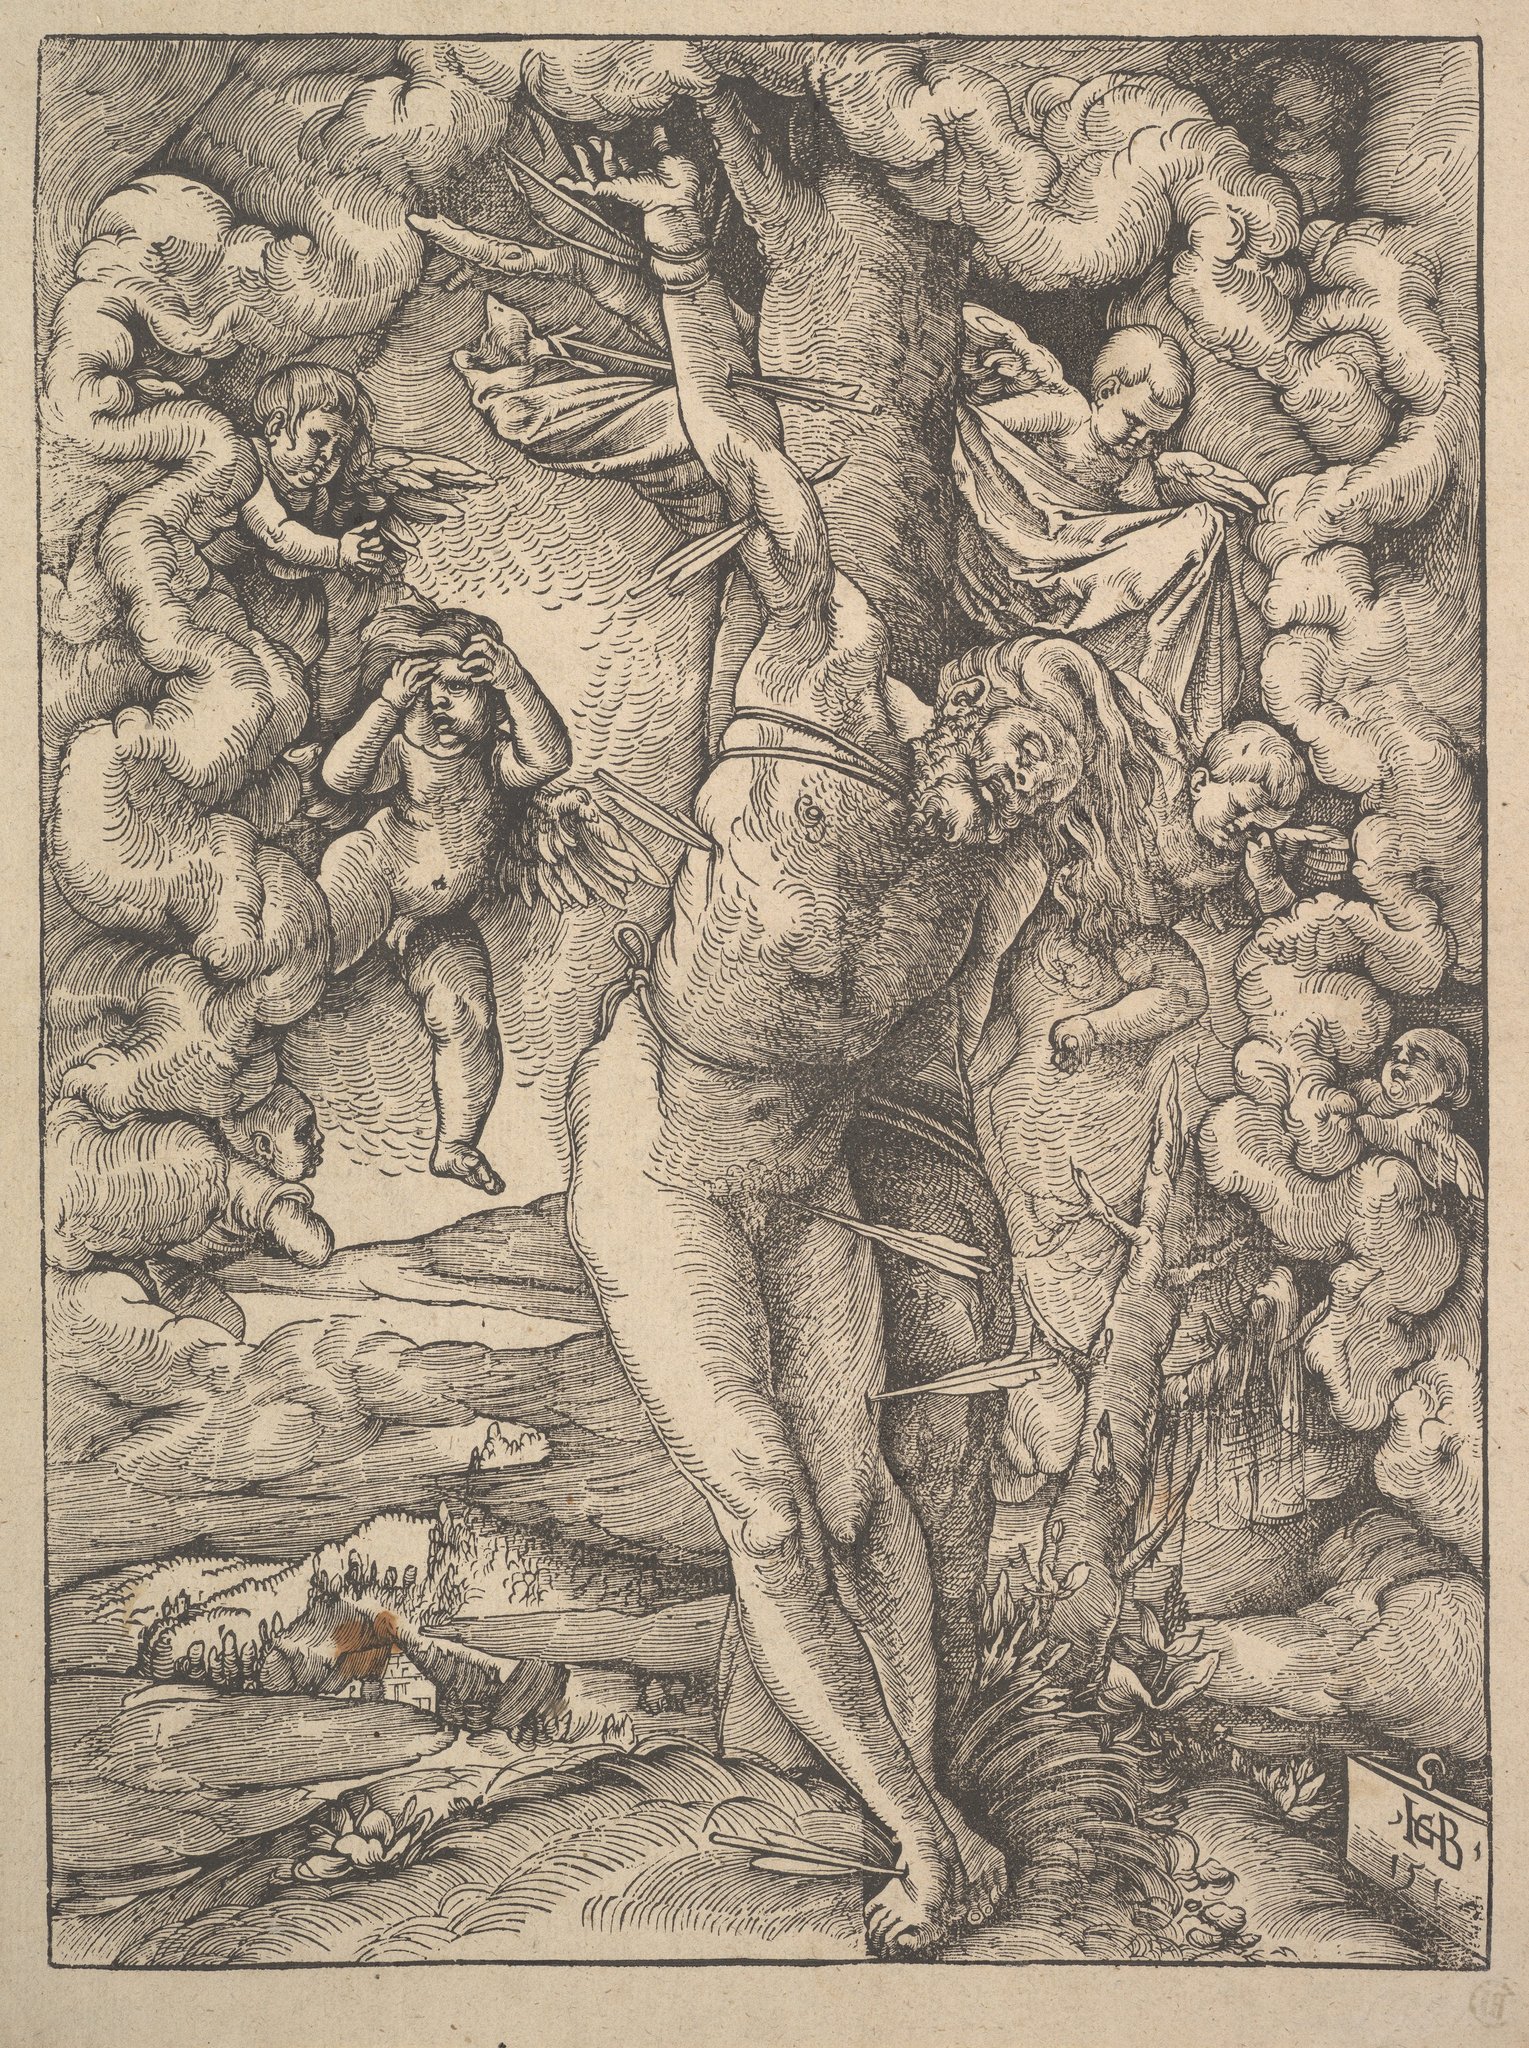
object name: print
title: St. Sebastian Bound to a Tree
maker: hans baldung (called hans baldung grien)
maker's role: artist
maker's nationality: german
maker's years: 1484-1545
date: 1514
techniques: woodcut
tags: arrows,saints